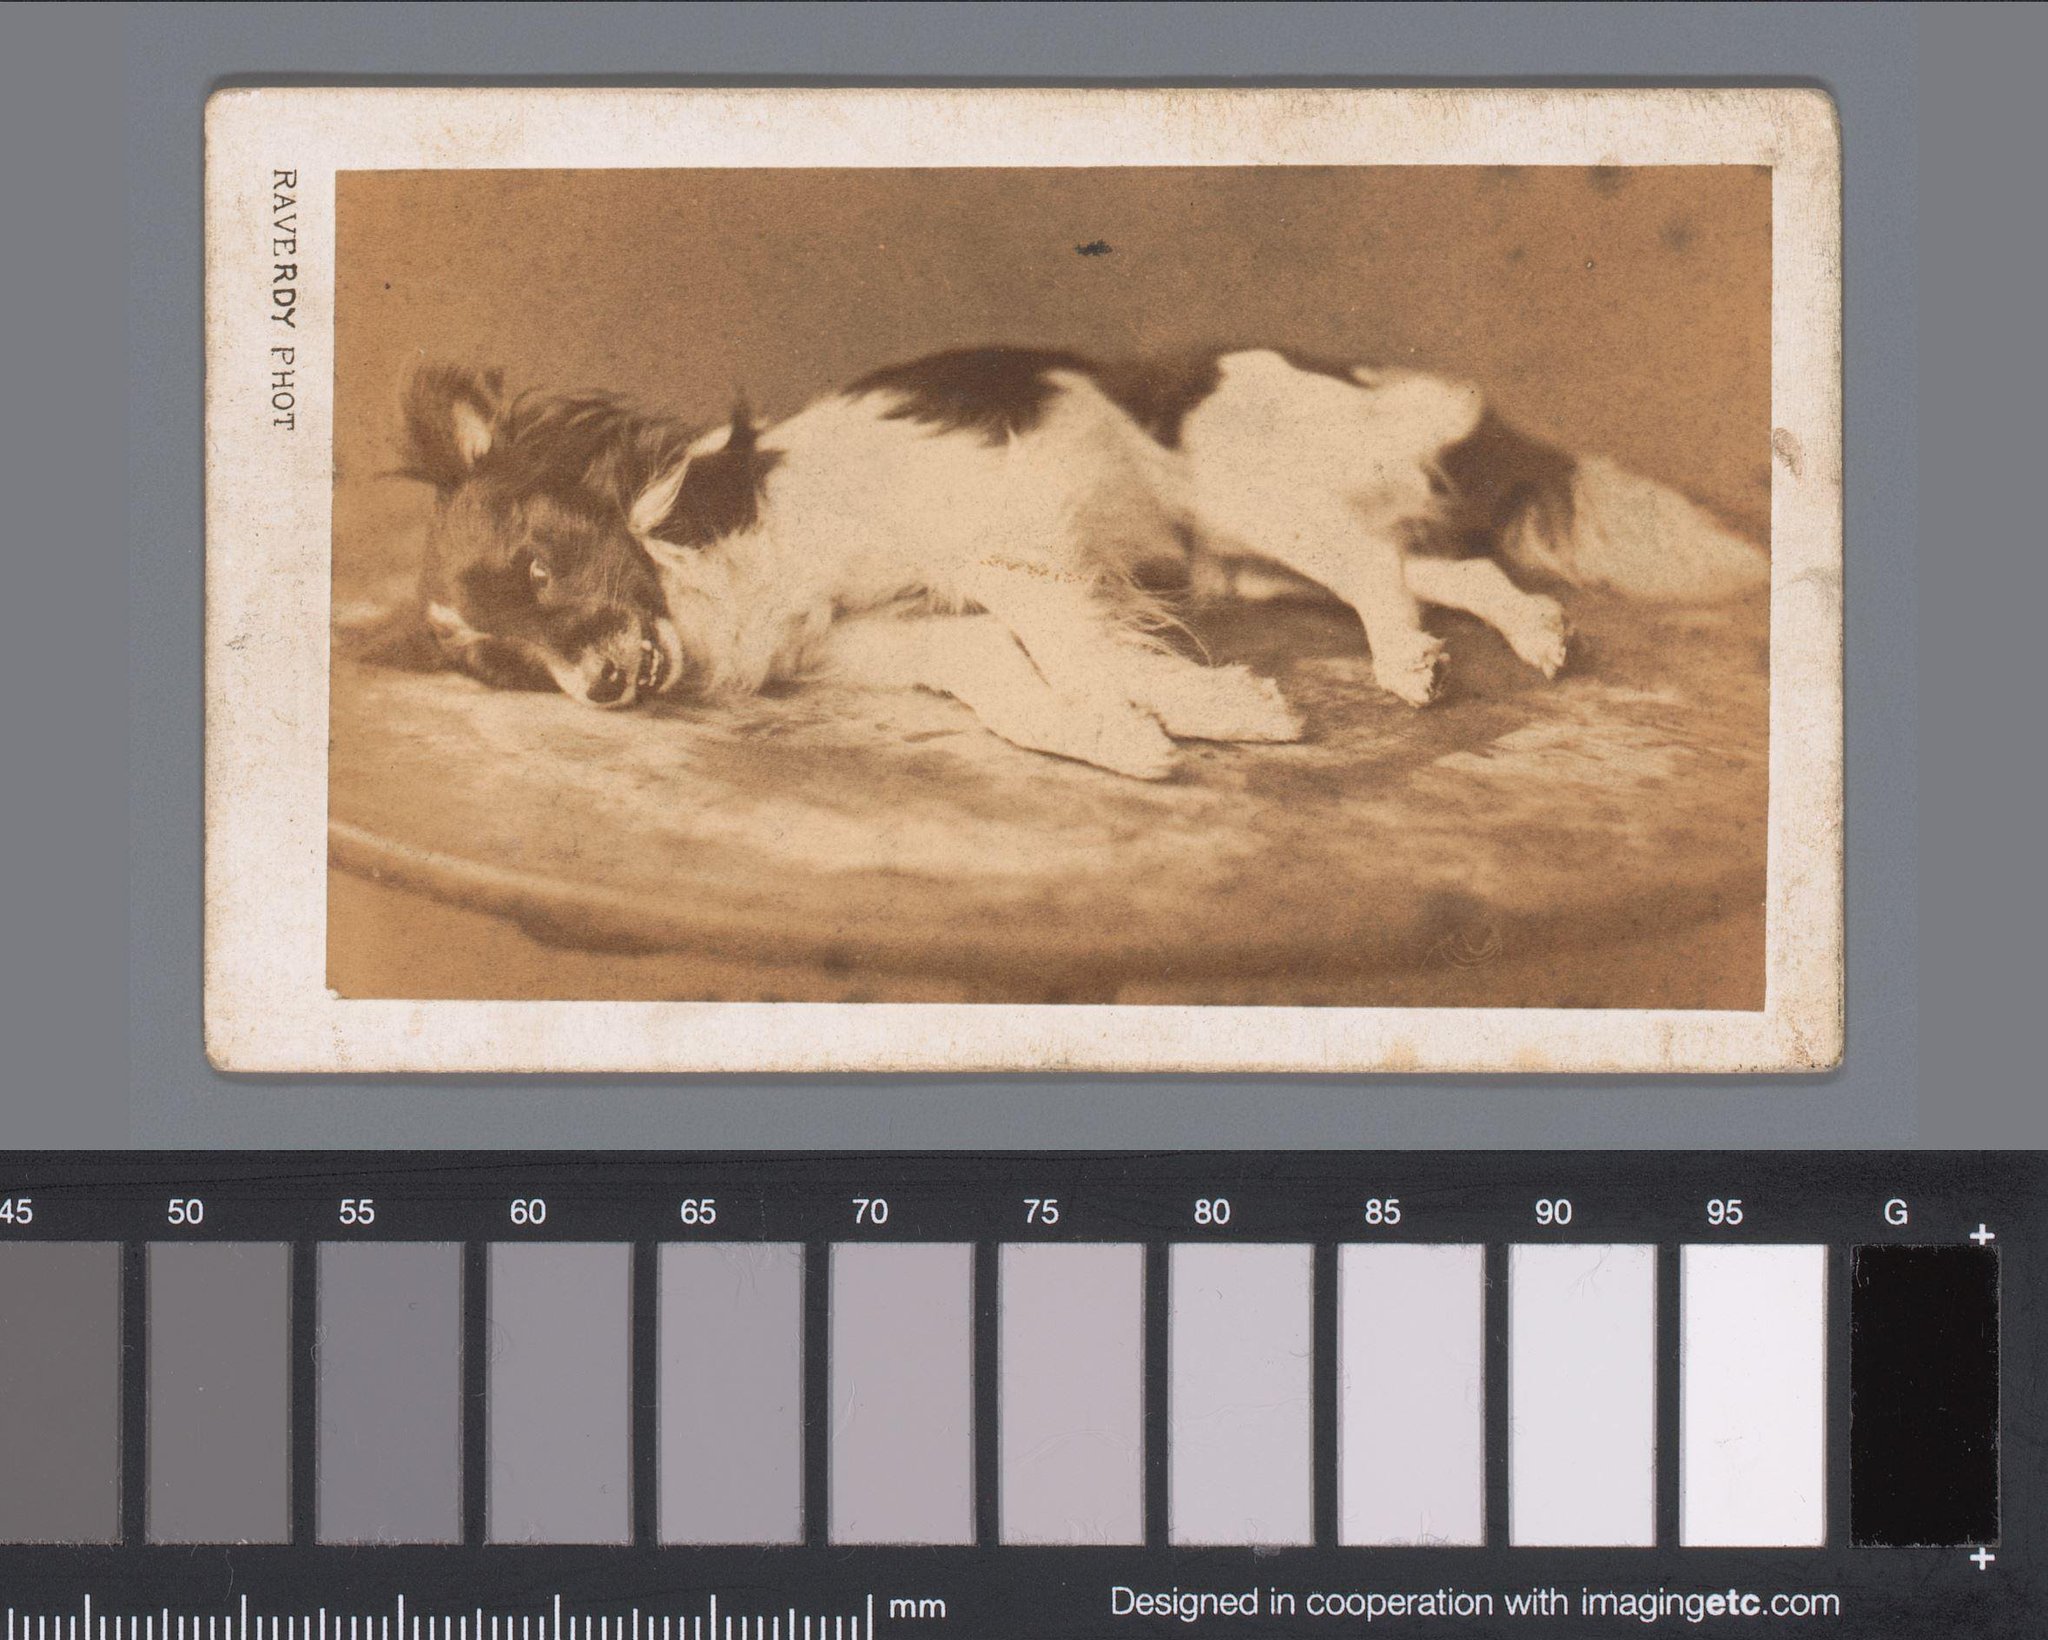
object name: photograph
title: Liggende hond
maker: raverdy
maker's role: fotograaf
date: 1855-1885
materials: cardboard, paper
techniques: albumen print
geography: valenciennes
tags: dog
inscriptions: address: ‘23, rue St. Géry, 23/ VALENCIENNES’